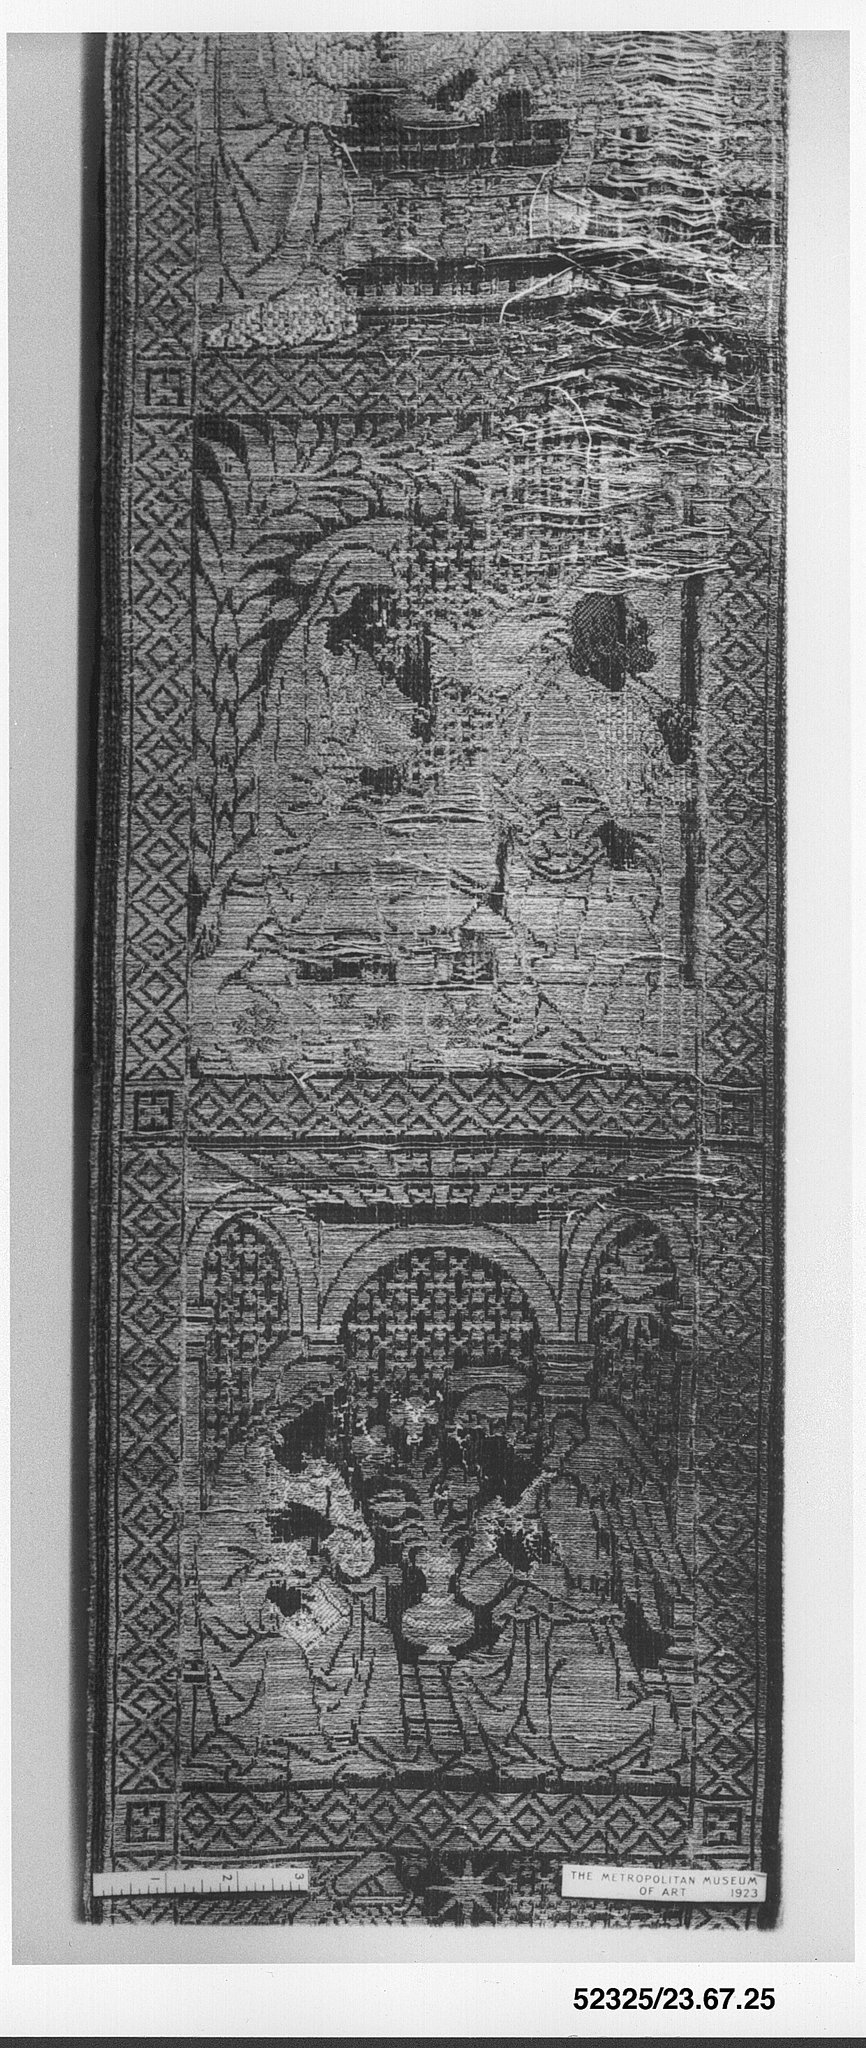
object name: orphrey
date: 1401-1500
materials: linen, metal thread, silk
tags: annunciation